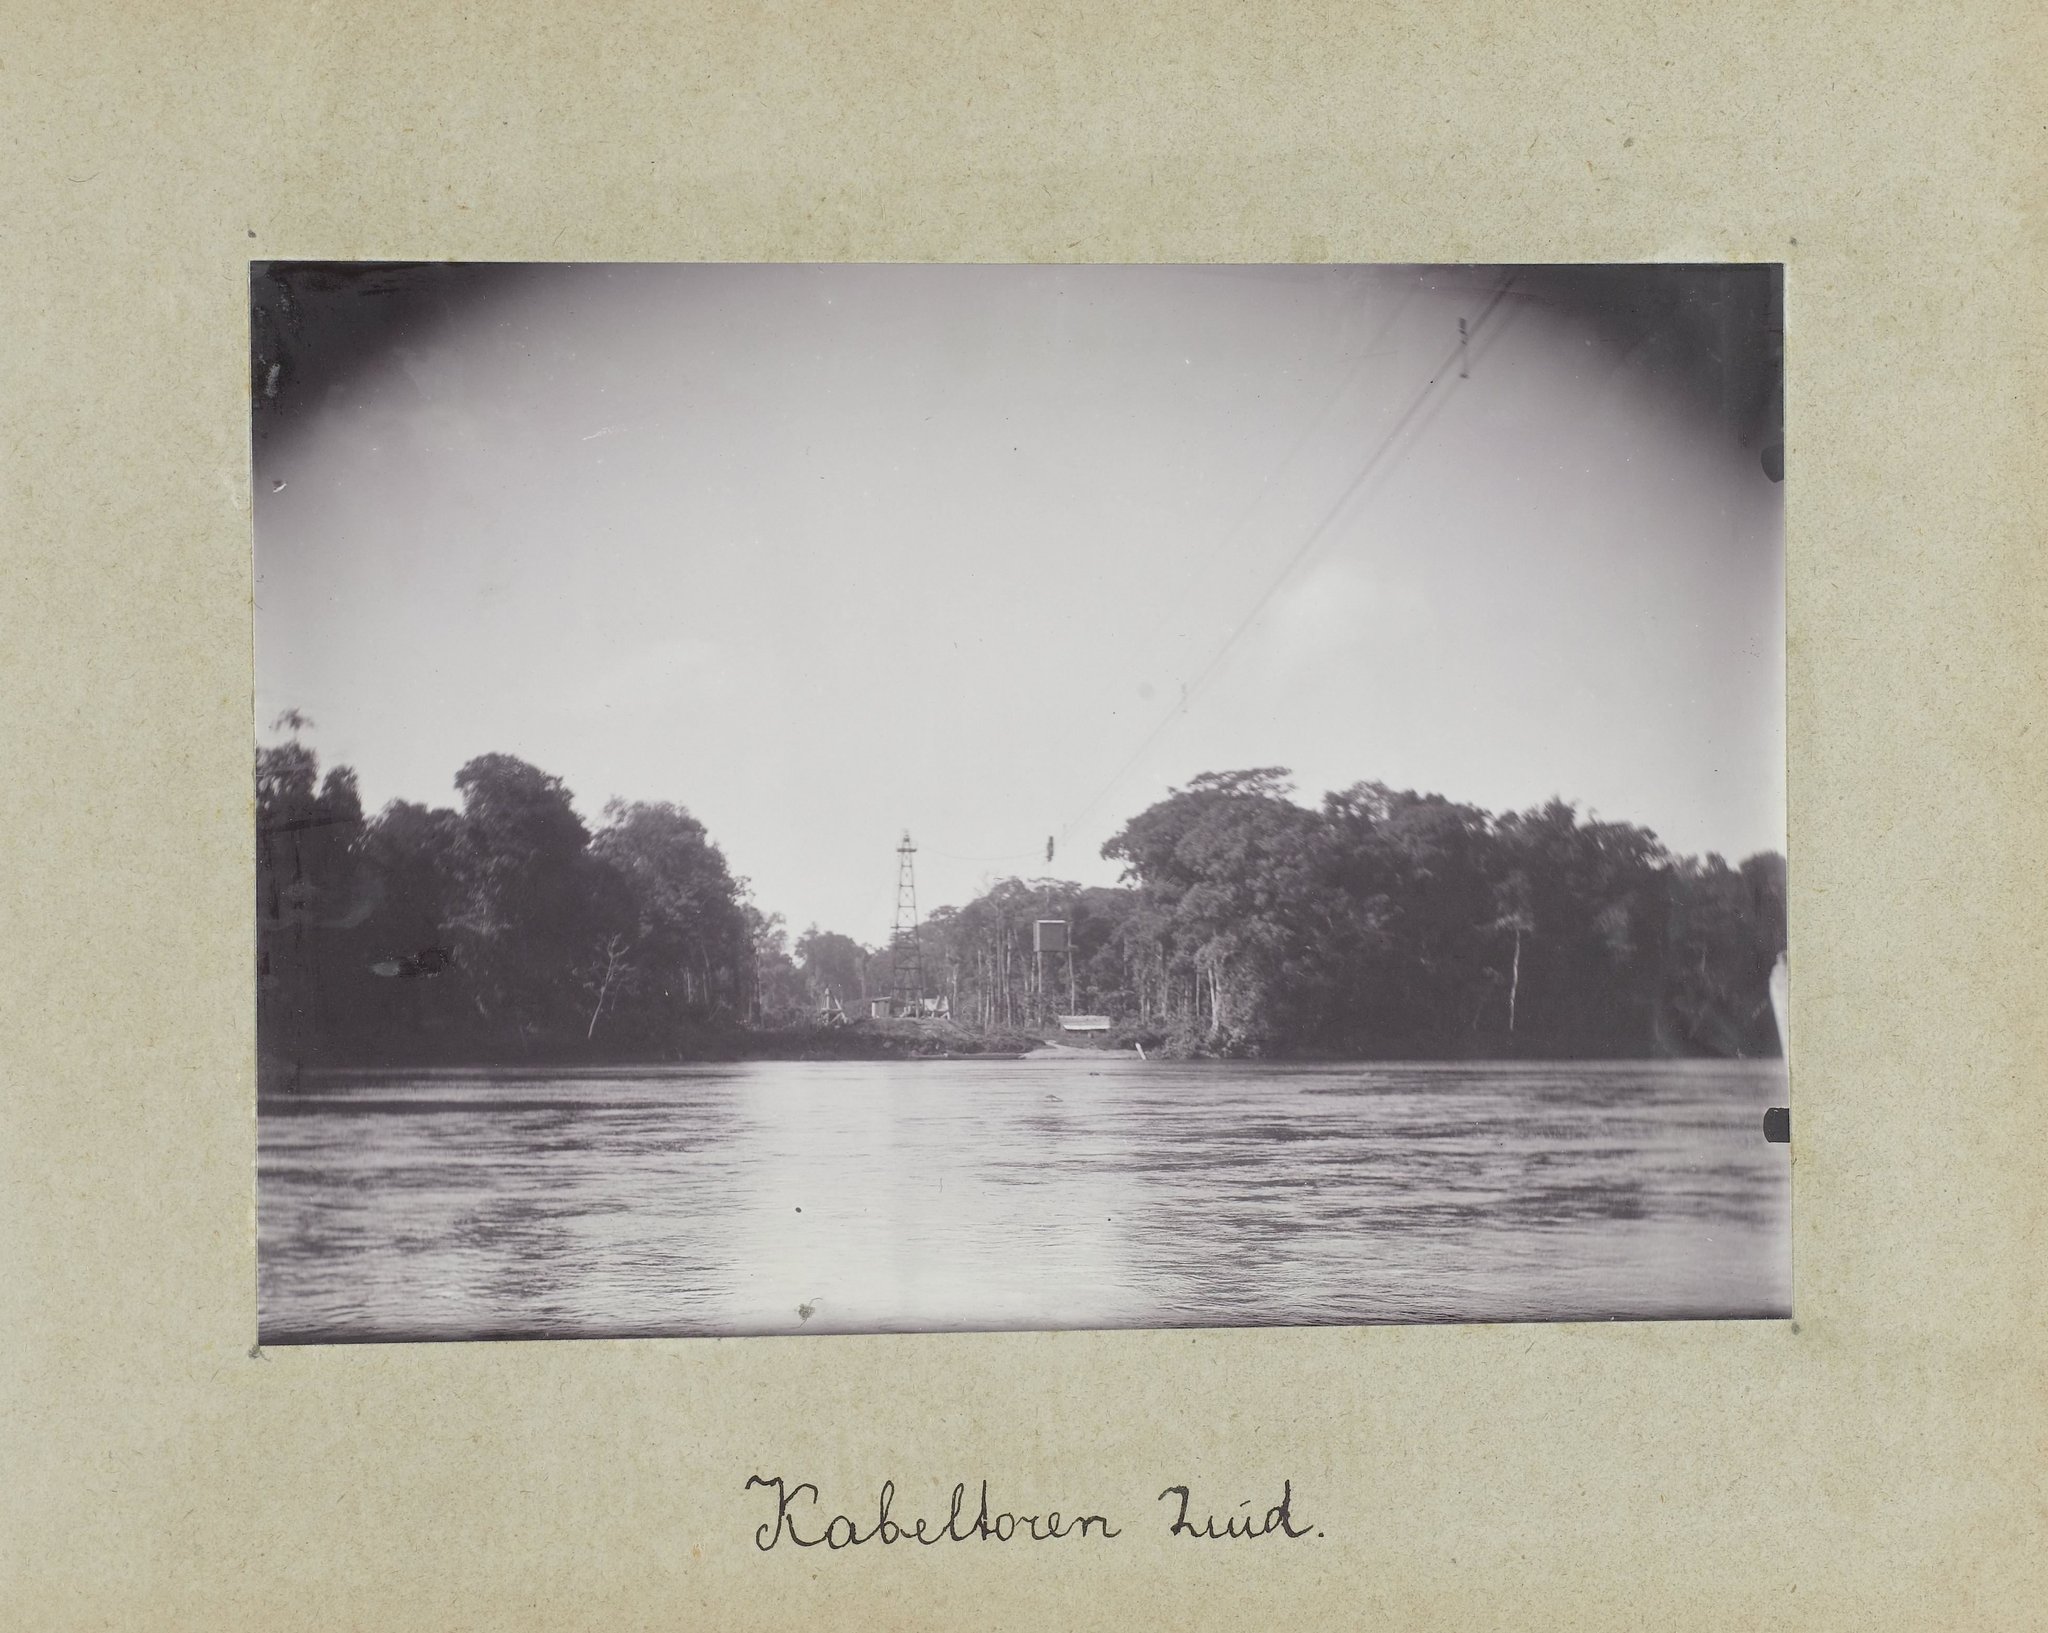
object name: photograph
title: Kabeltoren Zuid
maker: Anonymous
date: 1905-1910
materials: photographic support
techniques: photography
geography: suriname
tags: jacob evert wesenhagen, railway, tramway; rack railway, suriname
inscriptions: inscription: ‘Kabeltoren Zuid’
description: De kabeltoren aan de zuidzijde van de Surinamerivier. Foto in het fotoalbum over de aanleg van de Lawaspoorweg in Suriname in de jaren 1903-1912. Onderdeel van een groep objecten afkomstig van de familie Wesenhagen in Suriname.